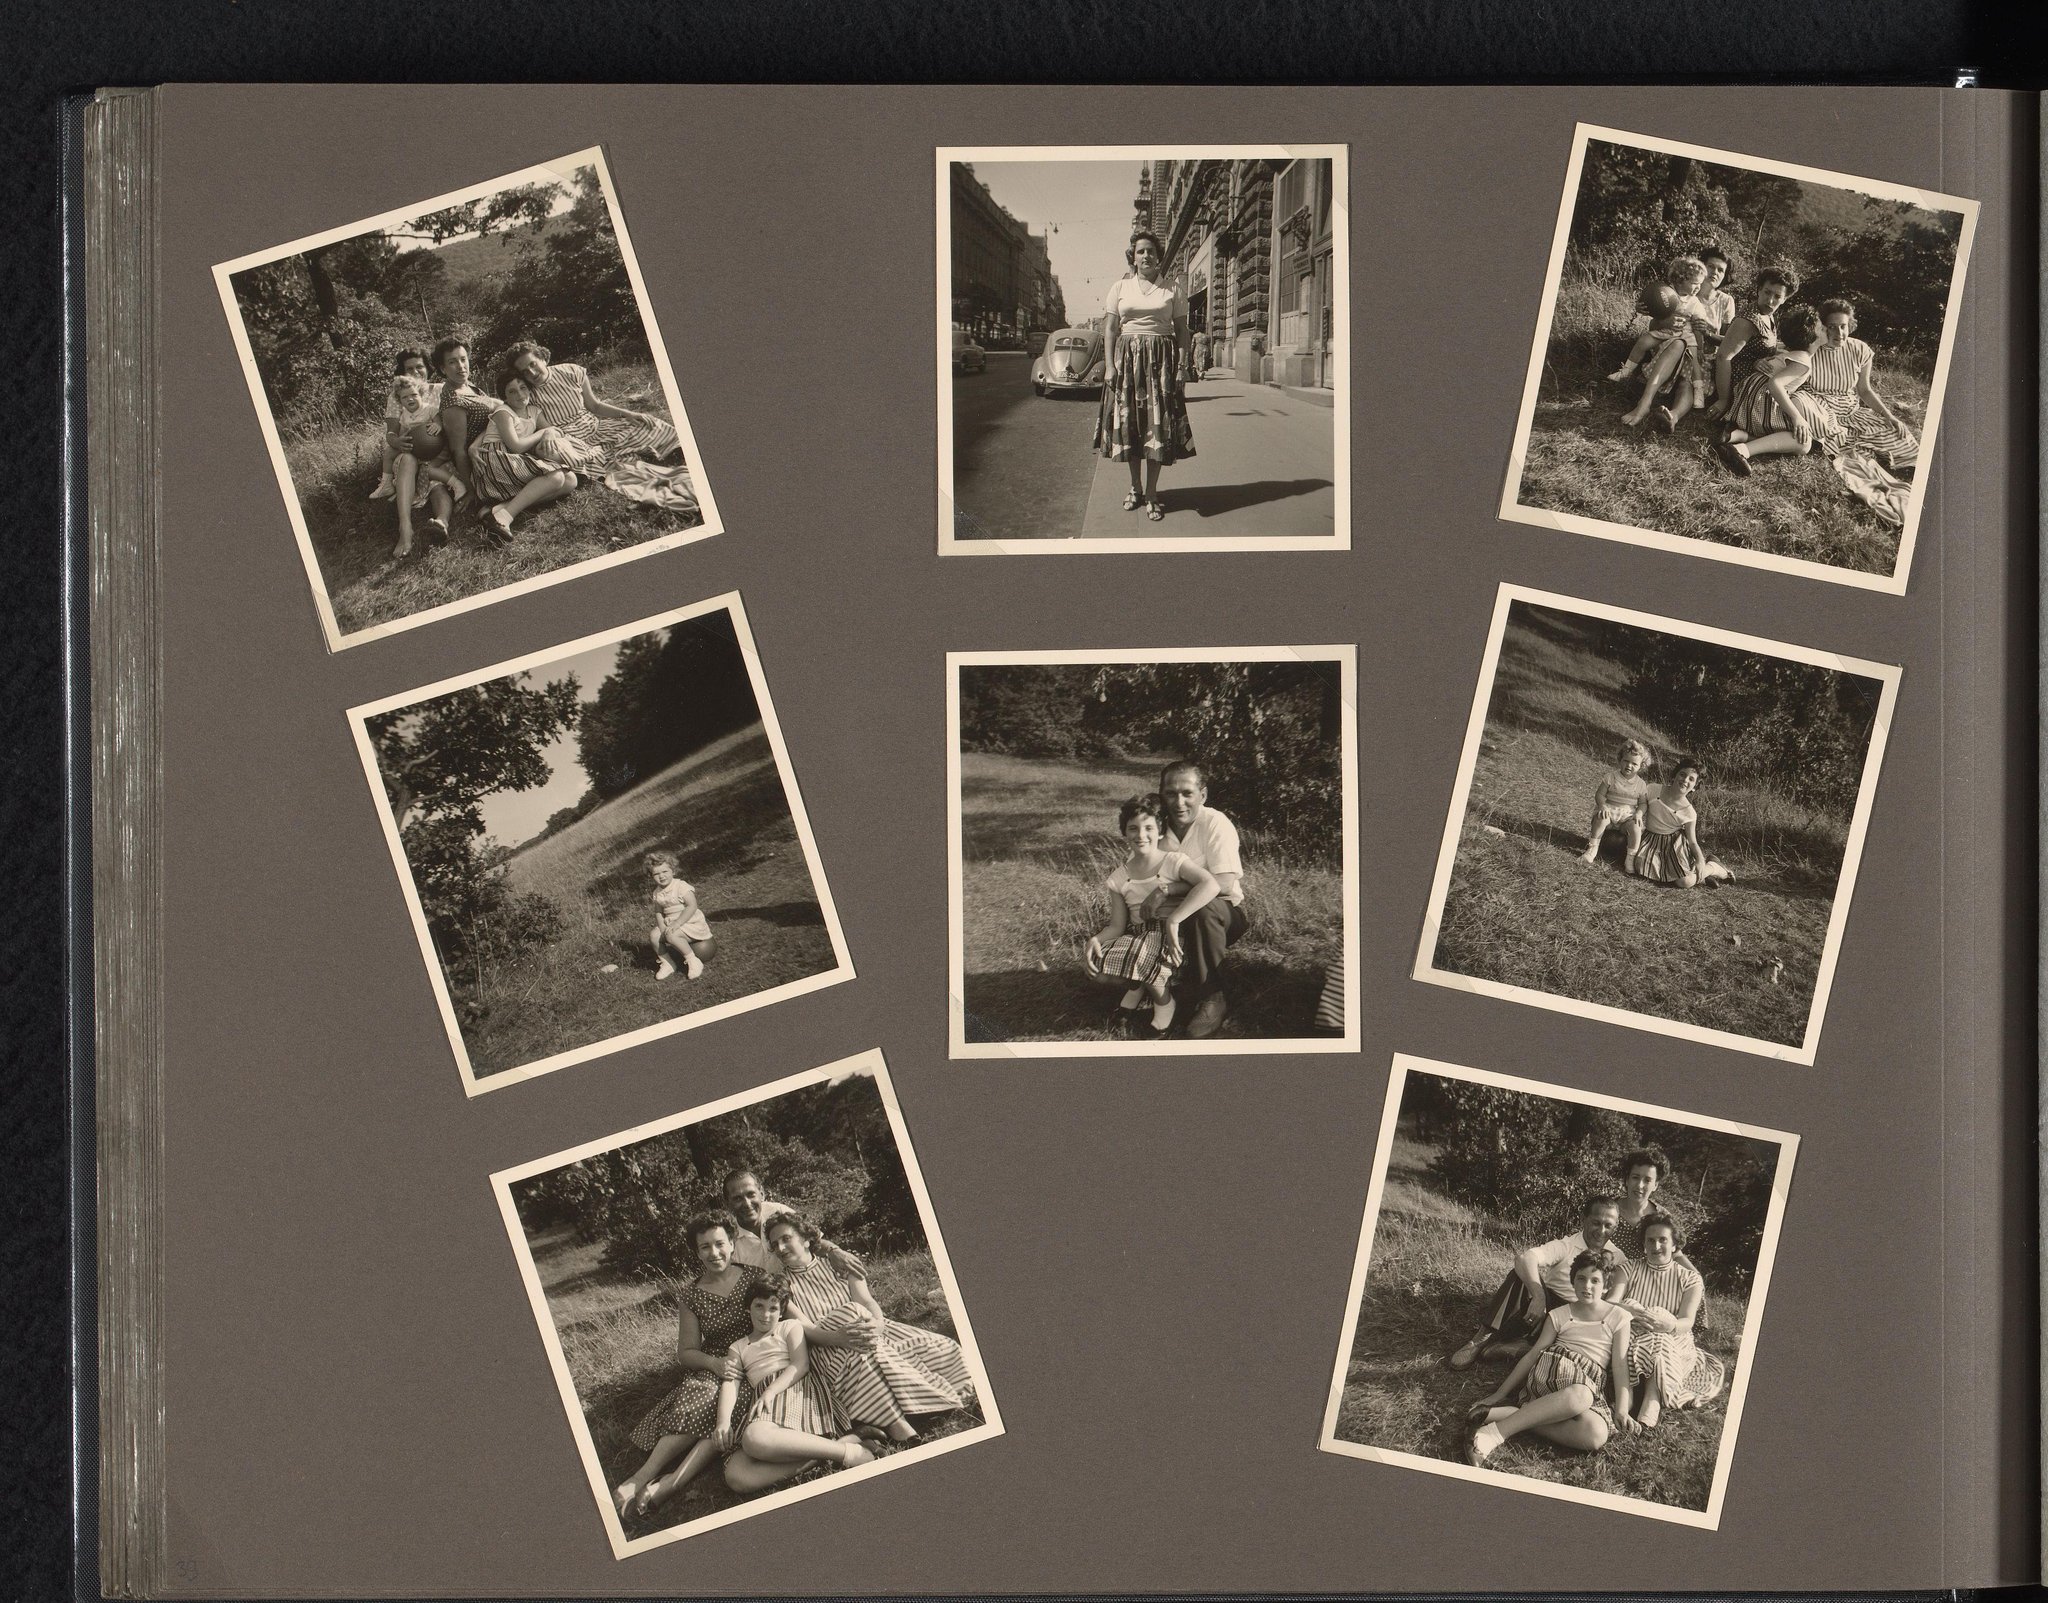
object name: photograph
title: Carol Elon met haar ouders Isabel Wachenheimer en Gideon Elon en een vrouw en meisje in de buitenlucht, mogelijk bij Wenen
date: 1960-1970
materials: paper, cardboard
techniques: gelatin silver print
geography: vienna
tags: leiden, isabel wachenheimer-elon, gideon elon, family group, especially parents with their child(ren), historical persons, meadow, pasture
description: Blad bevat acht foto's van Carol Elon (als jong meisje), Gideon Elon (enige man op de foto's), Isabel Wachenheimer (in gestreepte jurk), een meisje en een vrouw. Deze foto's maken deel uit van een album.